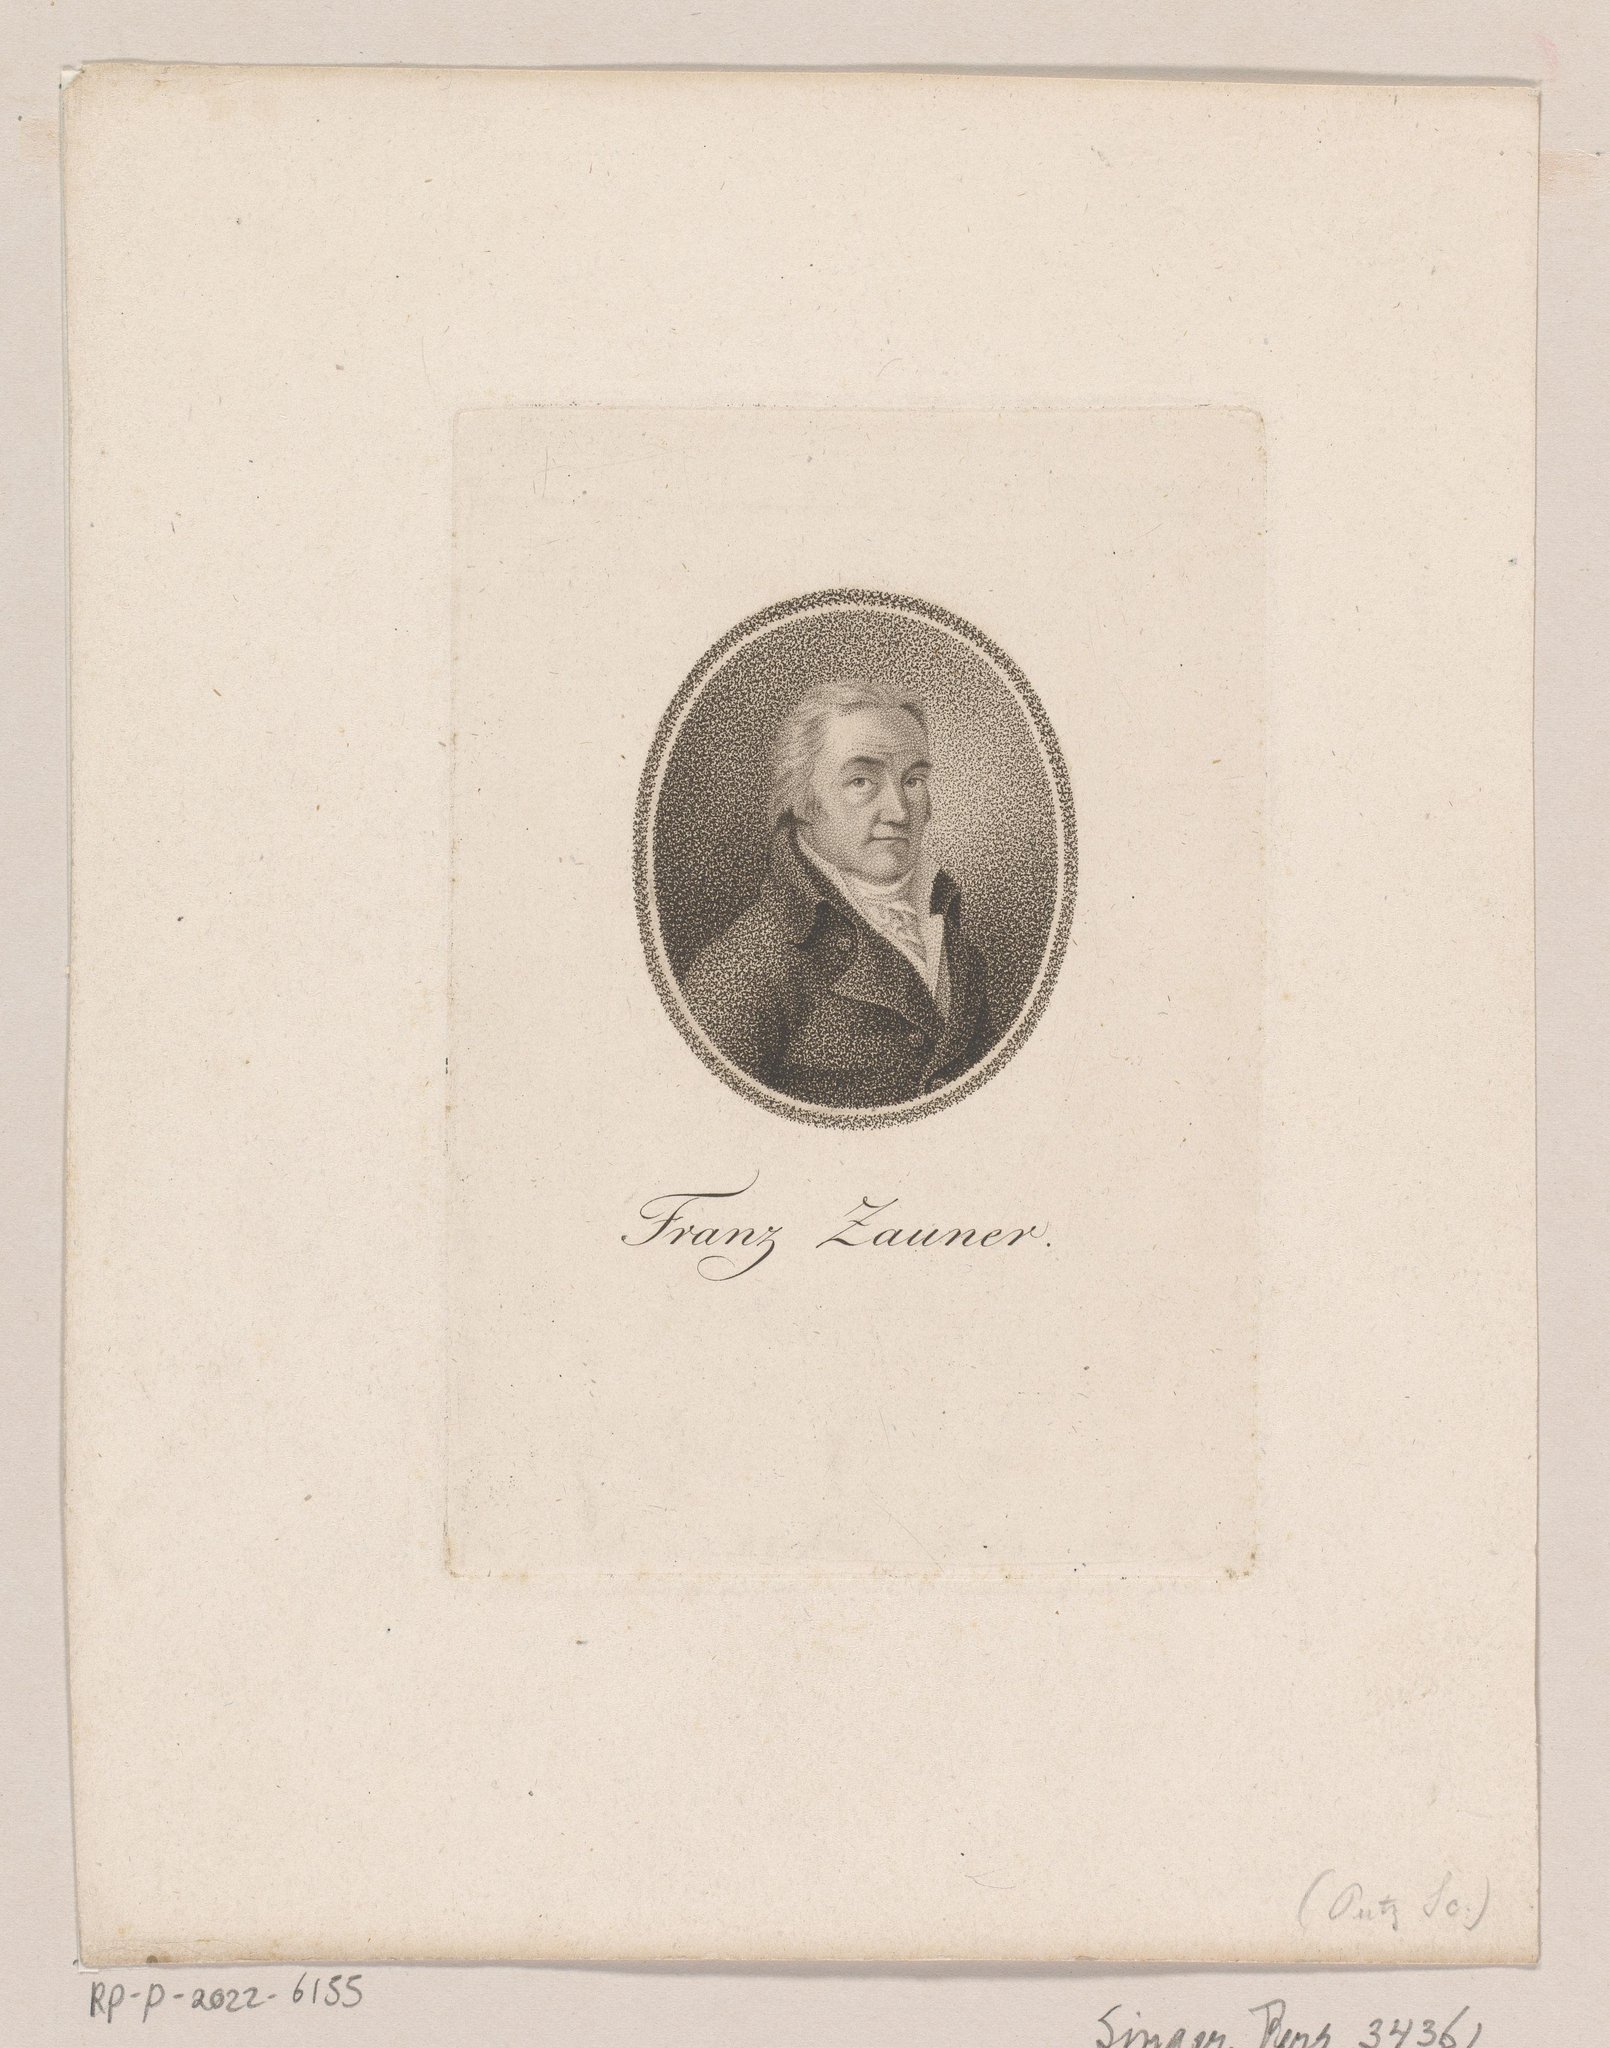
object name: print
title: Portret van Franz Anton Zauner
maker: Anonymous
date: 1770-1850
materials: paper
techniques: stippling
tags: vienna, sculptor, franz anton zauner, portrait, self-portrait of sculptor, historical persons